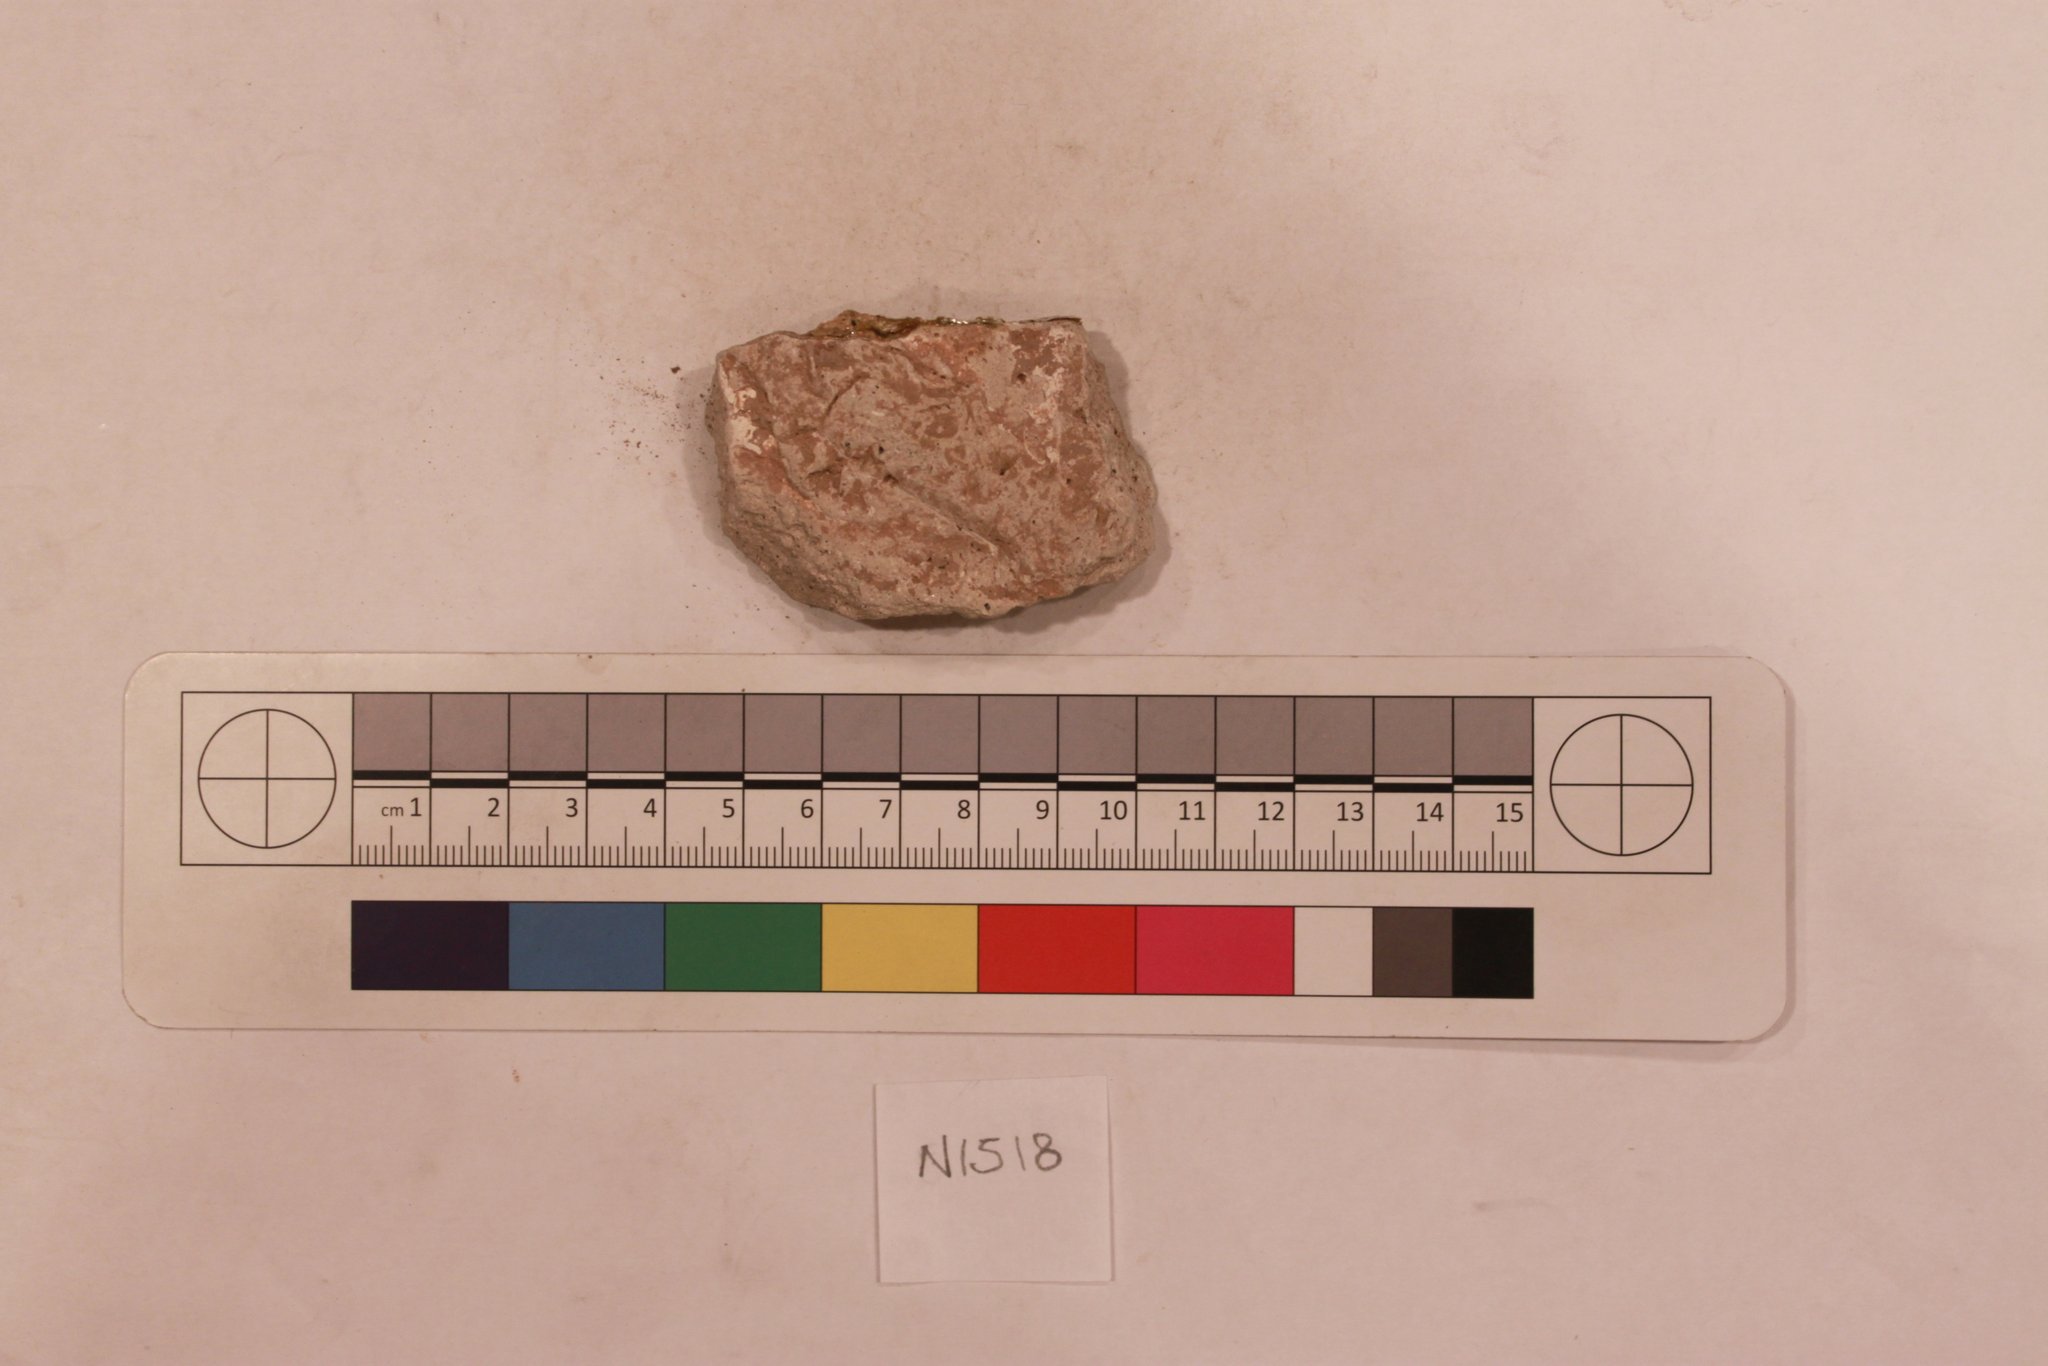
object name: fragment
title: Stucco Fragment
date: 701-1200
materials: plaster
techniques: carving, painting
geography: iran